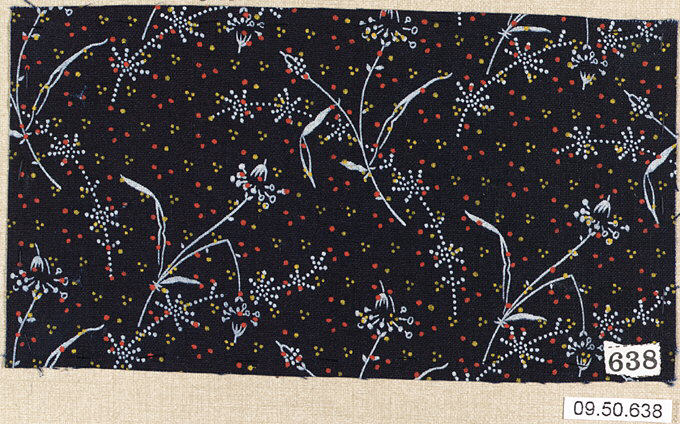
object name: piece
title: Pieces (8)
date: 1801-1900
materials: cotton